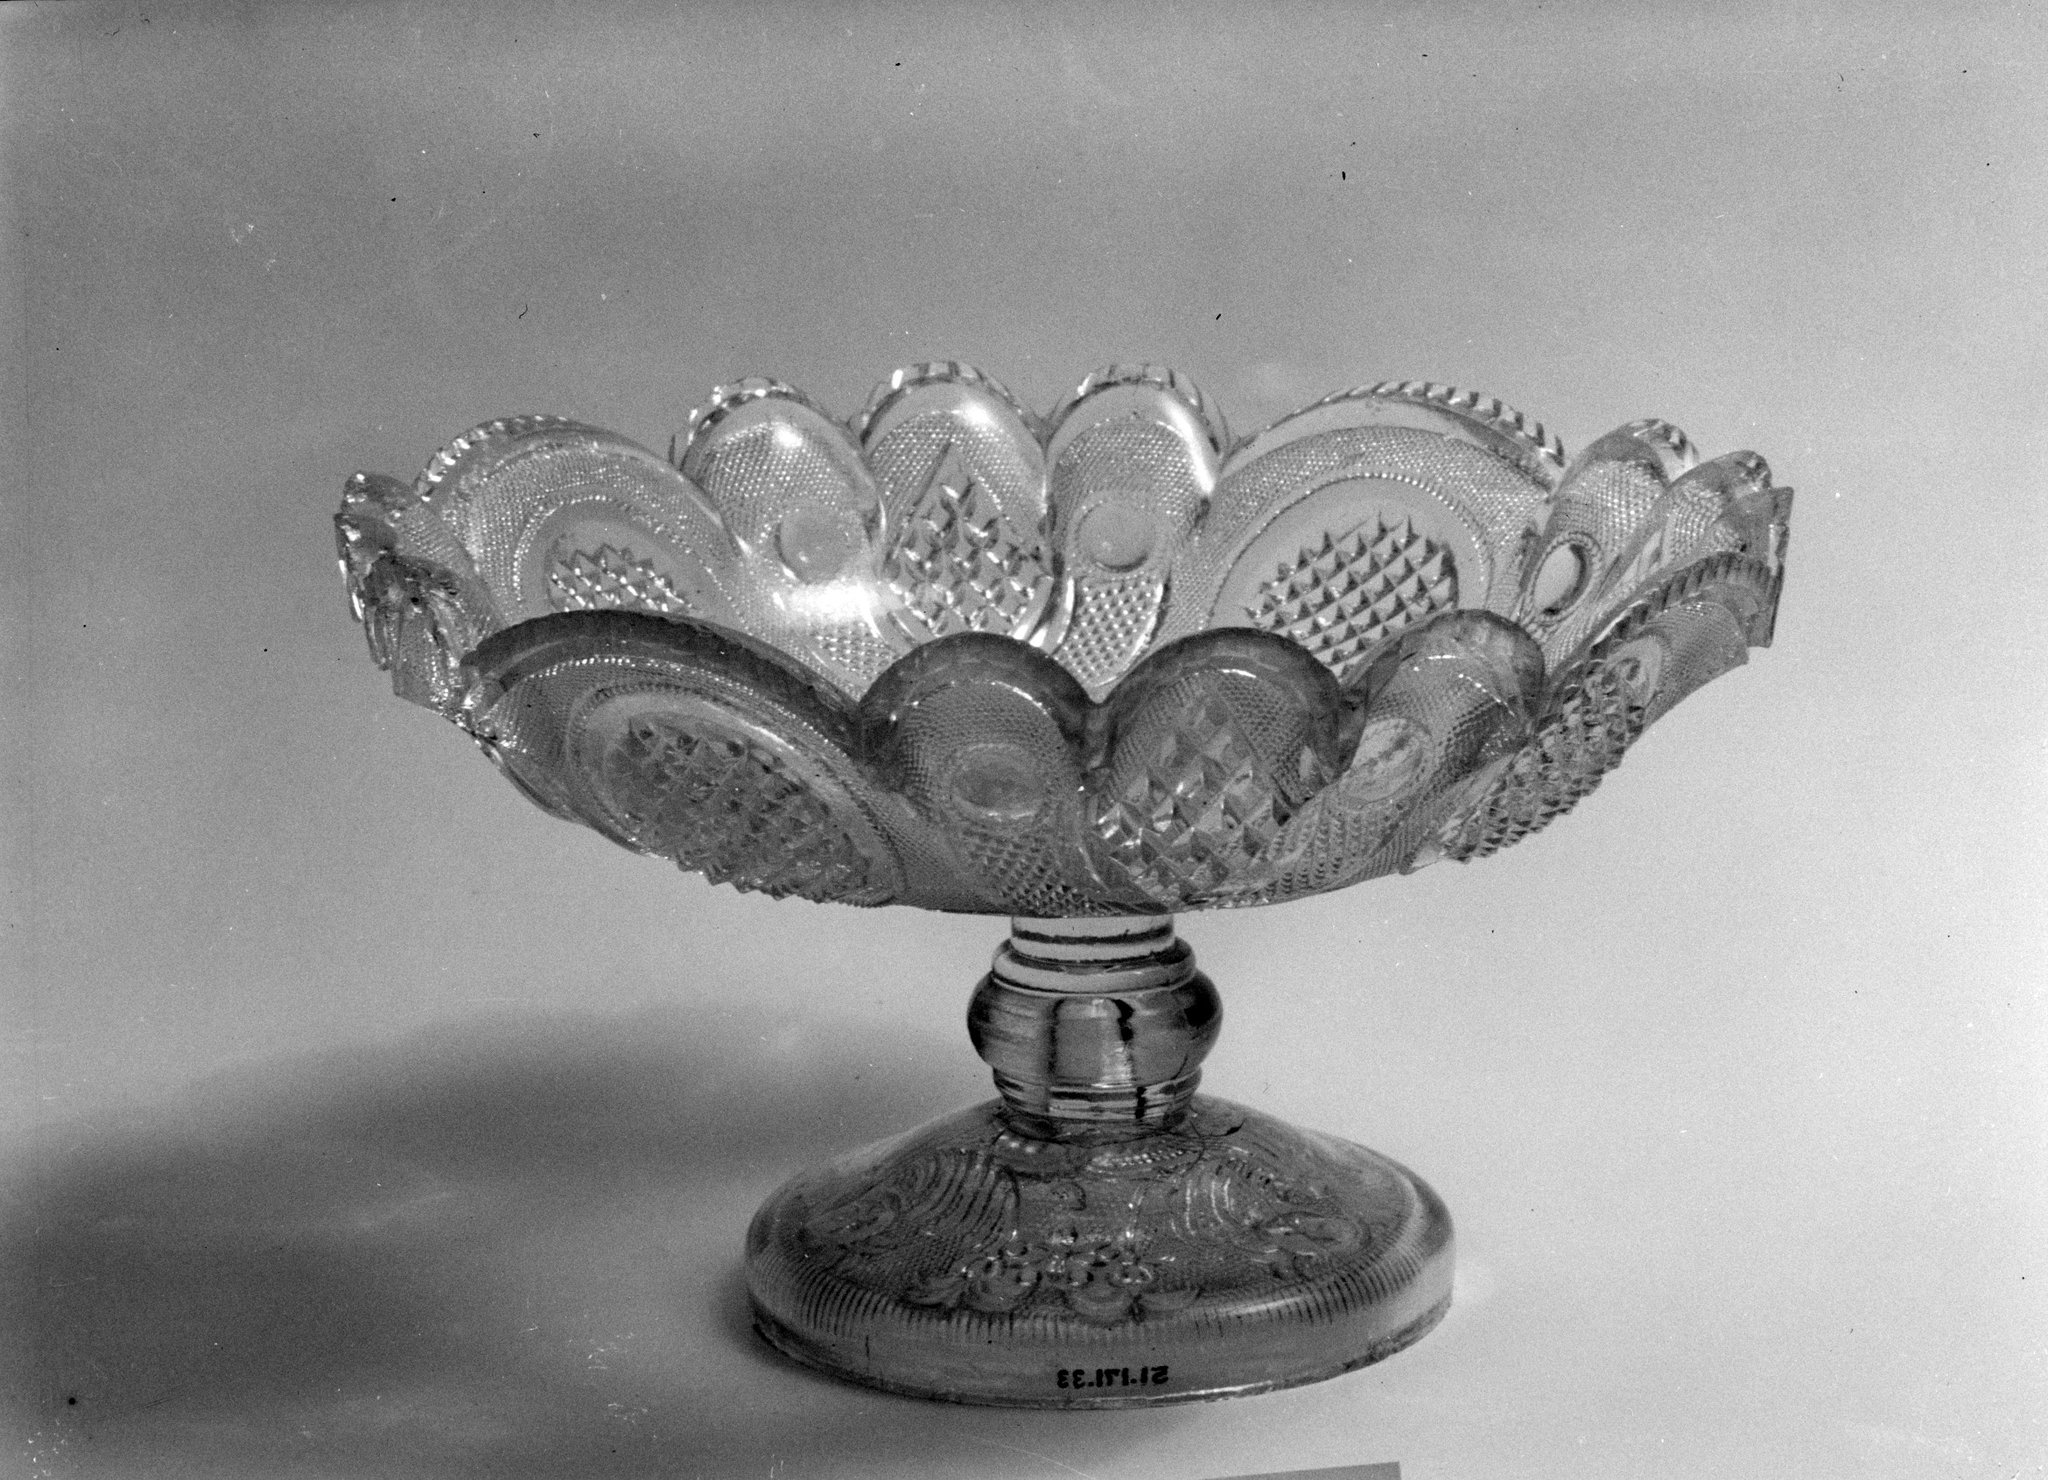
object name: compote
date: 1801-1900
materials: glass